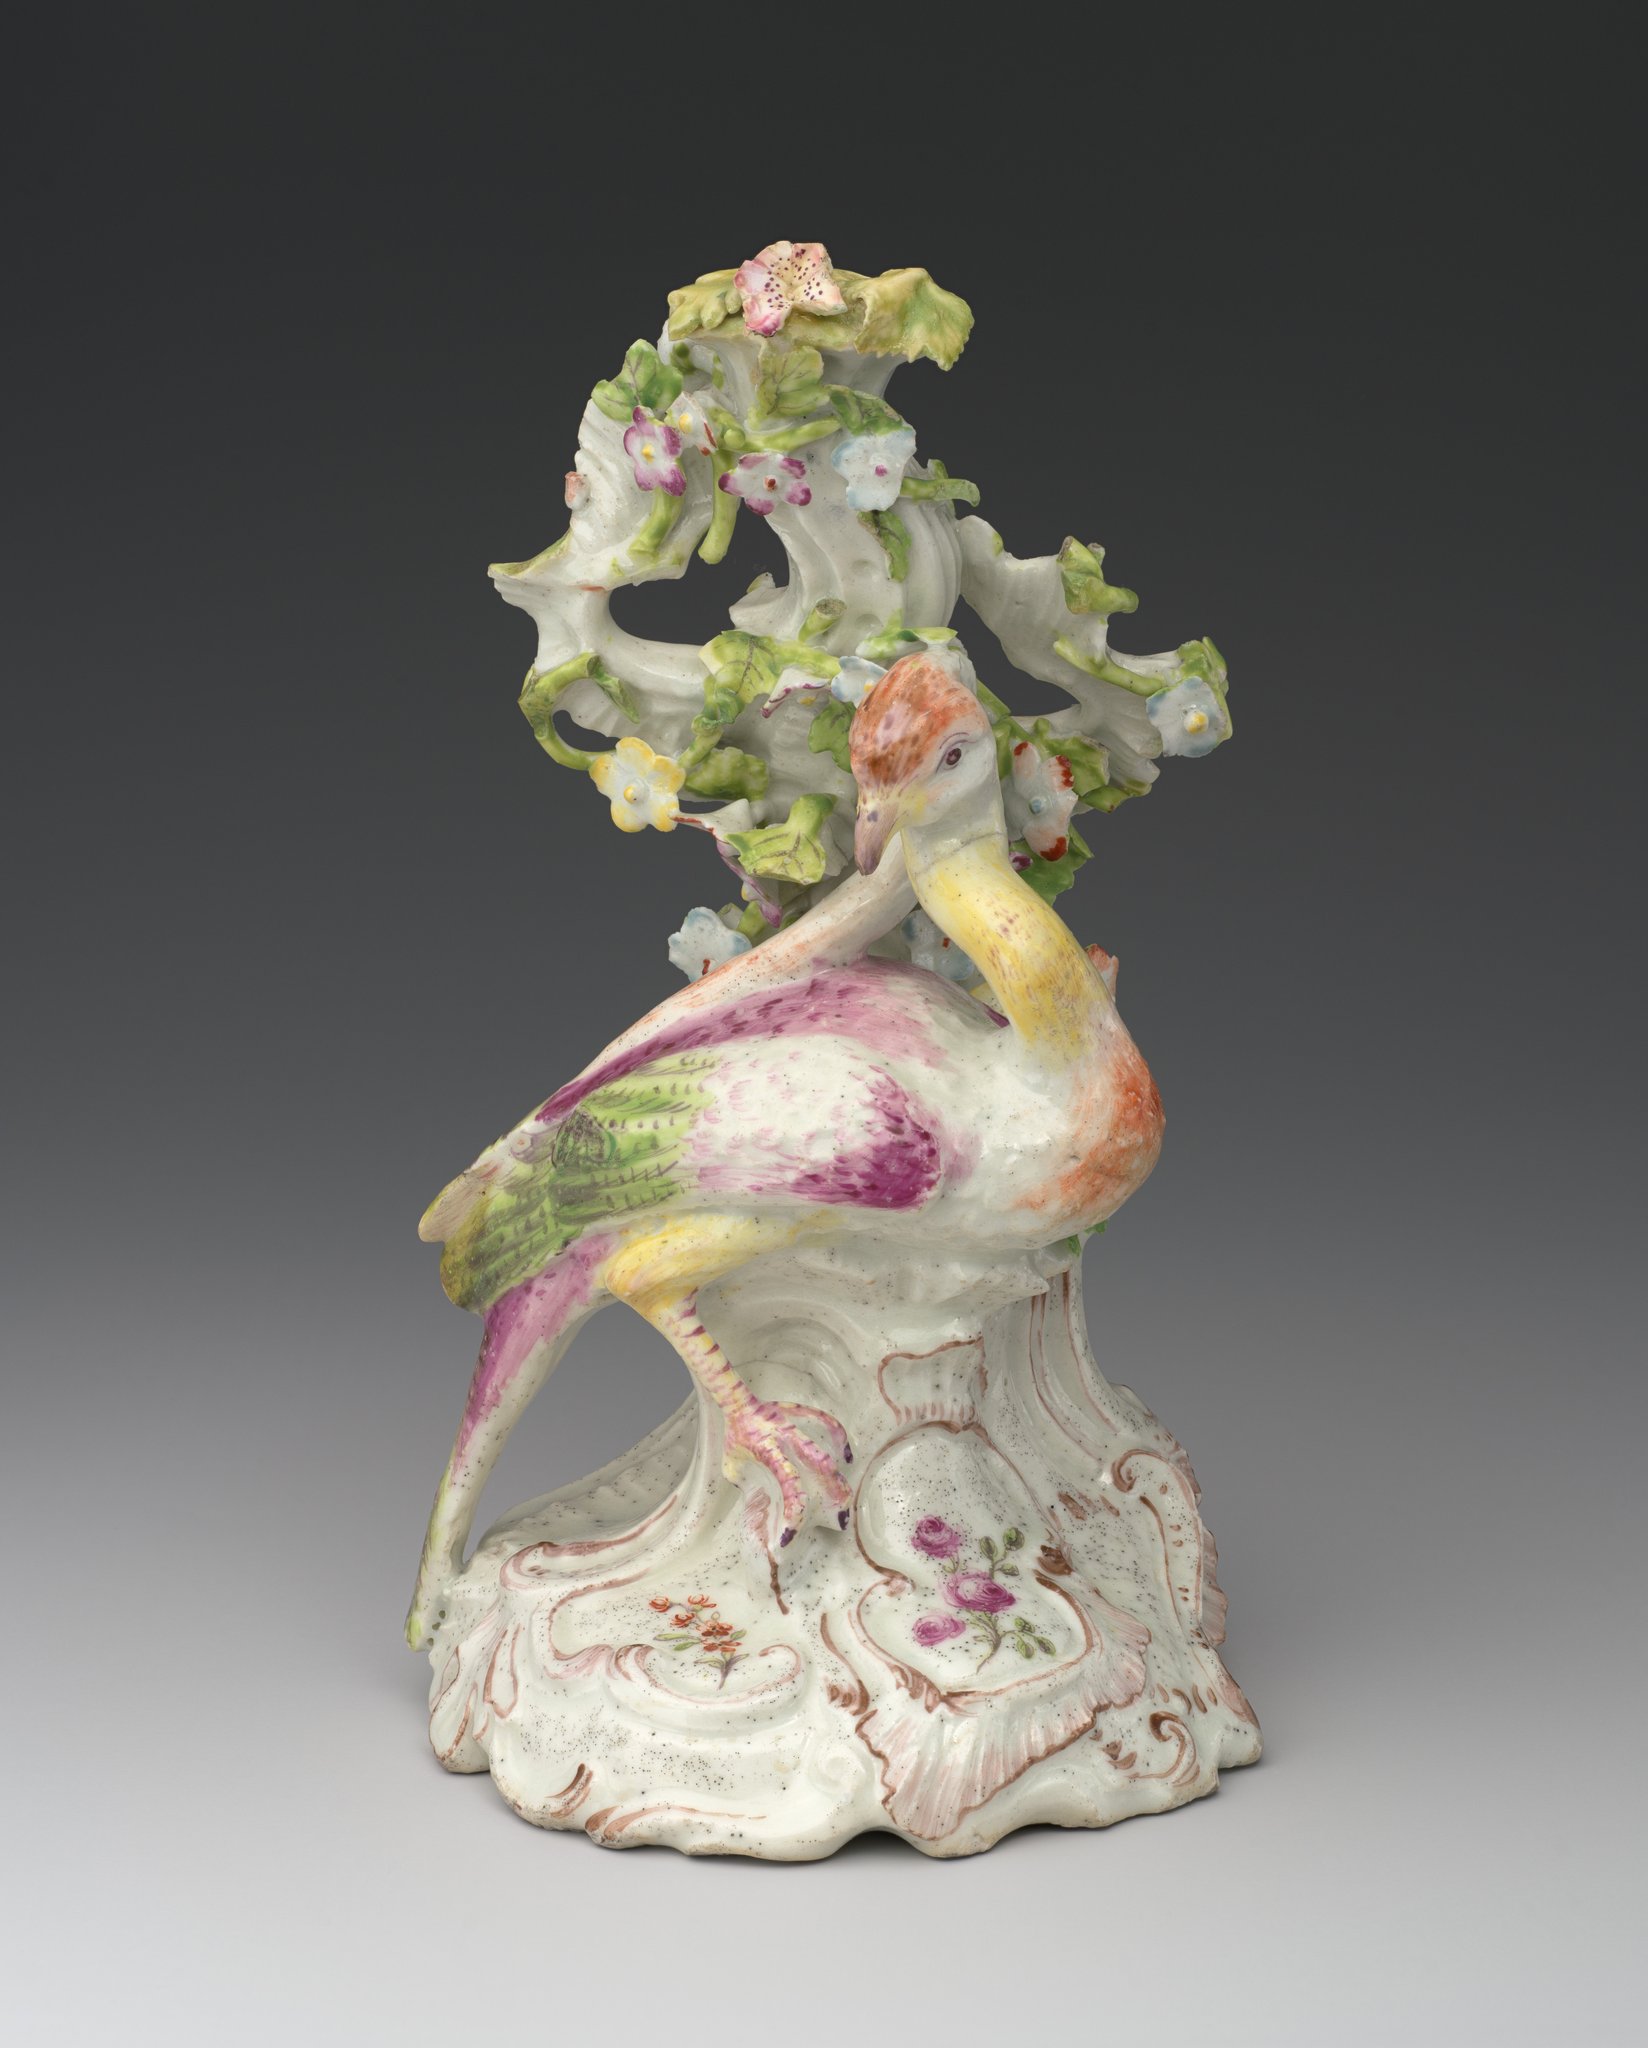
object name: figure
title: Crested pheasant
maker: derby porcelain manufactory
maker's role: factory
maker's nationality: british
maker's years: 1751-1785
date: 1755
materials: soft paste porcelain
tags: pheasants